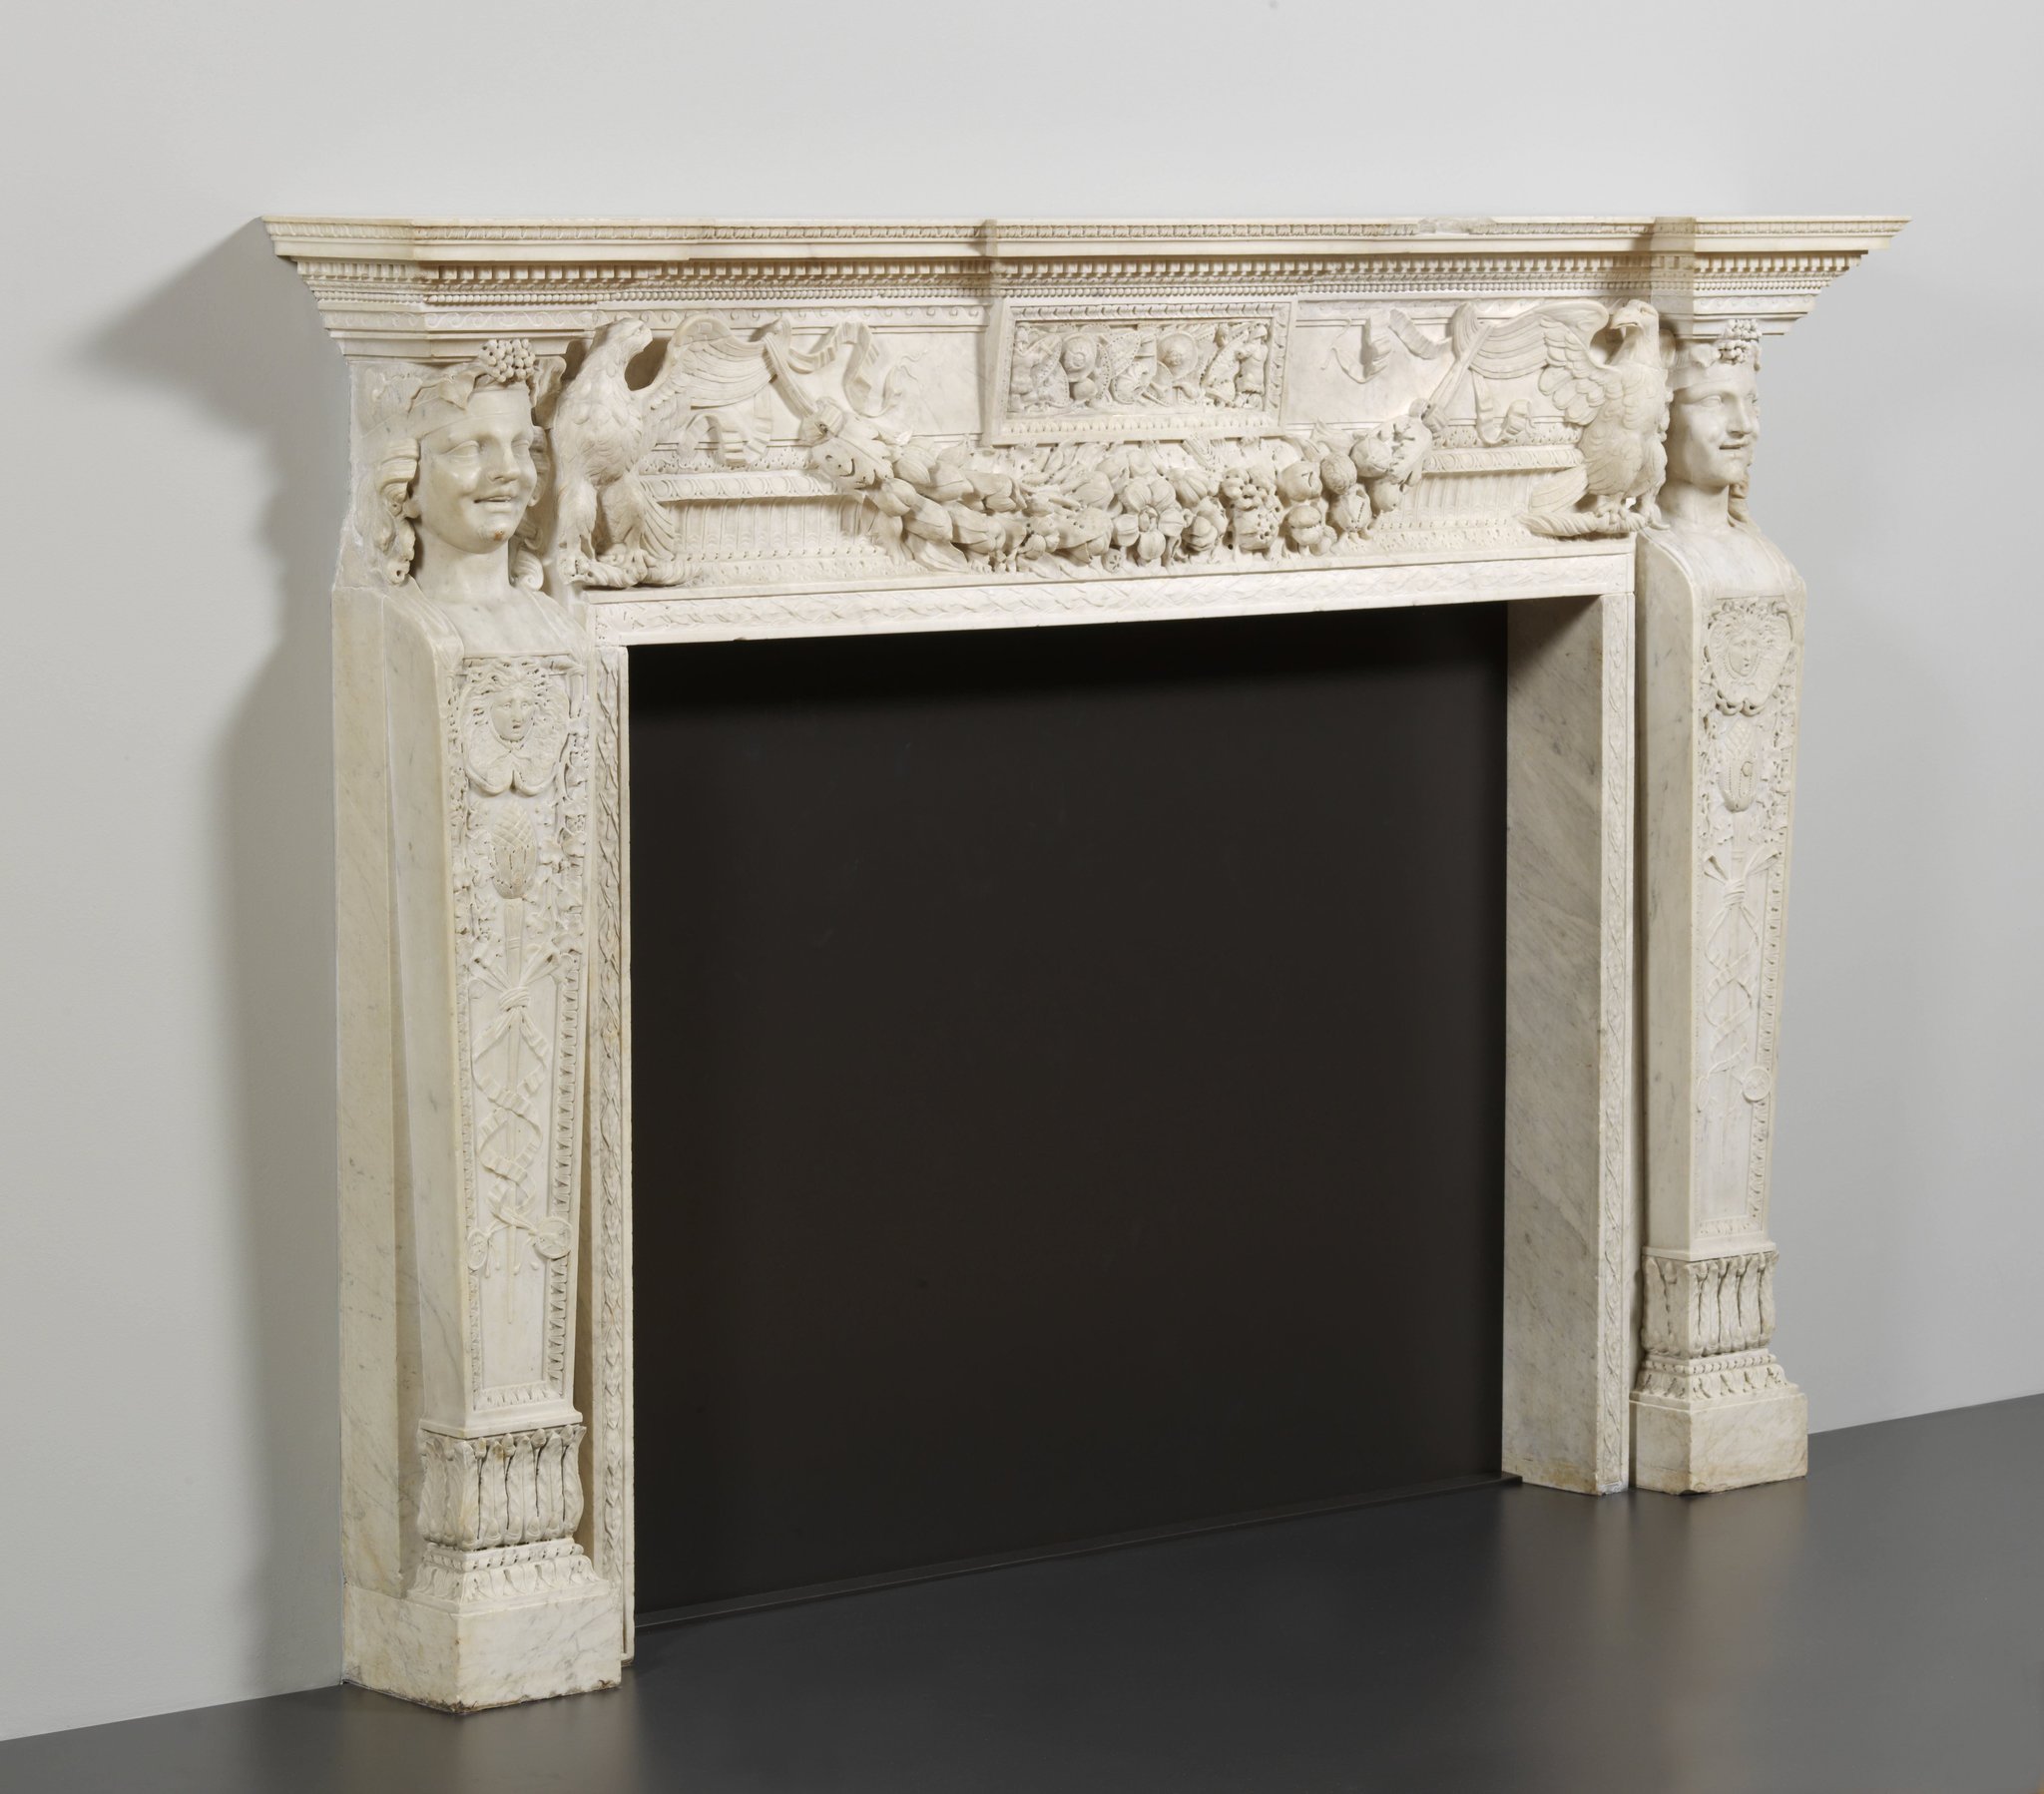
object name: relief sculpture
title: Chimneypiece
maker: giovanni battista piranesi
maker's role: designer, draughtsman, print maker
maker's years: 1720-1778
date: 1761-1769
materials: marble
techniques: carved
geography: rome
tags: mask, mascaron ~ ornament, ornament ~ festoon, garland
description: This chimneypiece was designed and made by the renowned Italian architect Piranesi, who incorporated in it fragments of ancient Roman sculpture. Piranesi here applied his archaeological interest in Classical antiquity to an innovative design in a Neoclassical style. The Amsterdam banker John Hope bought the chimneypiece from Piranesi in Rome.